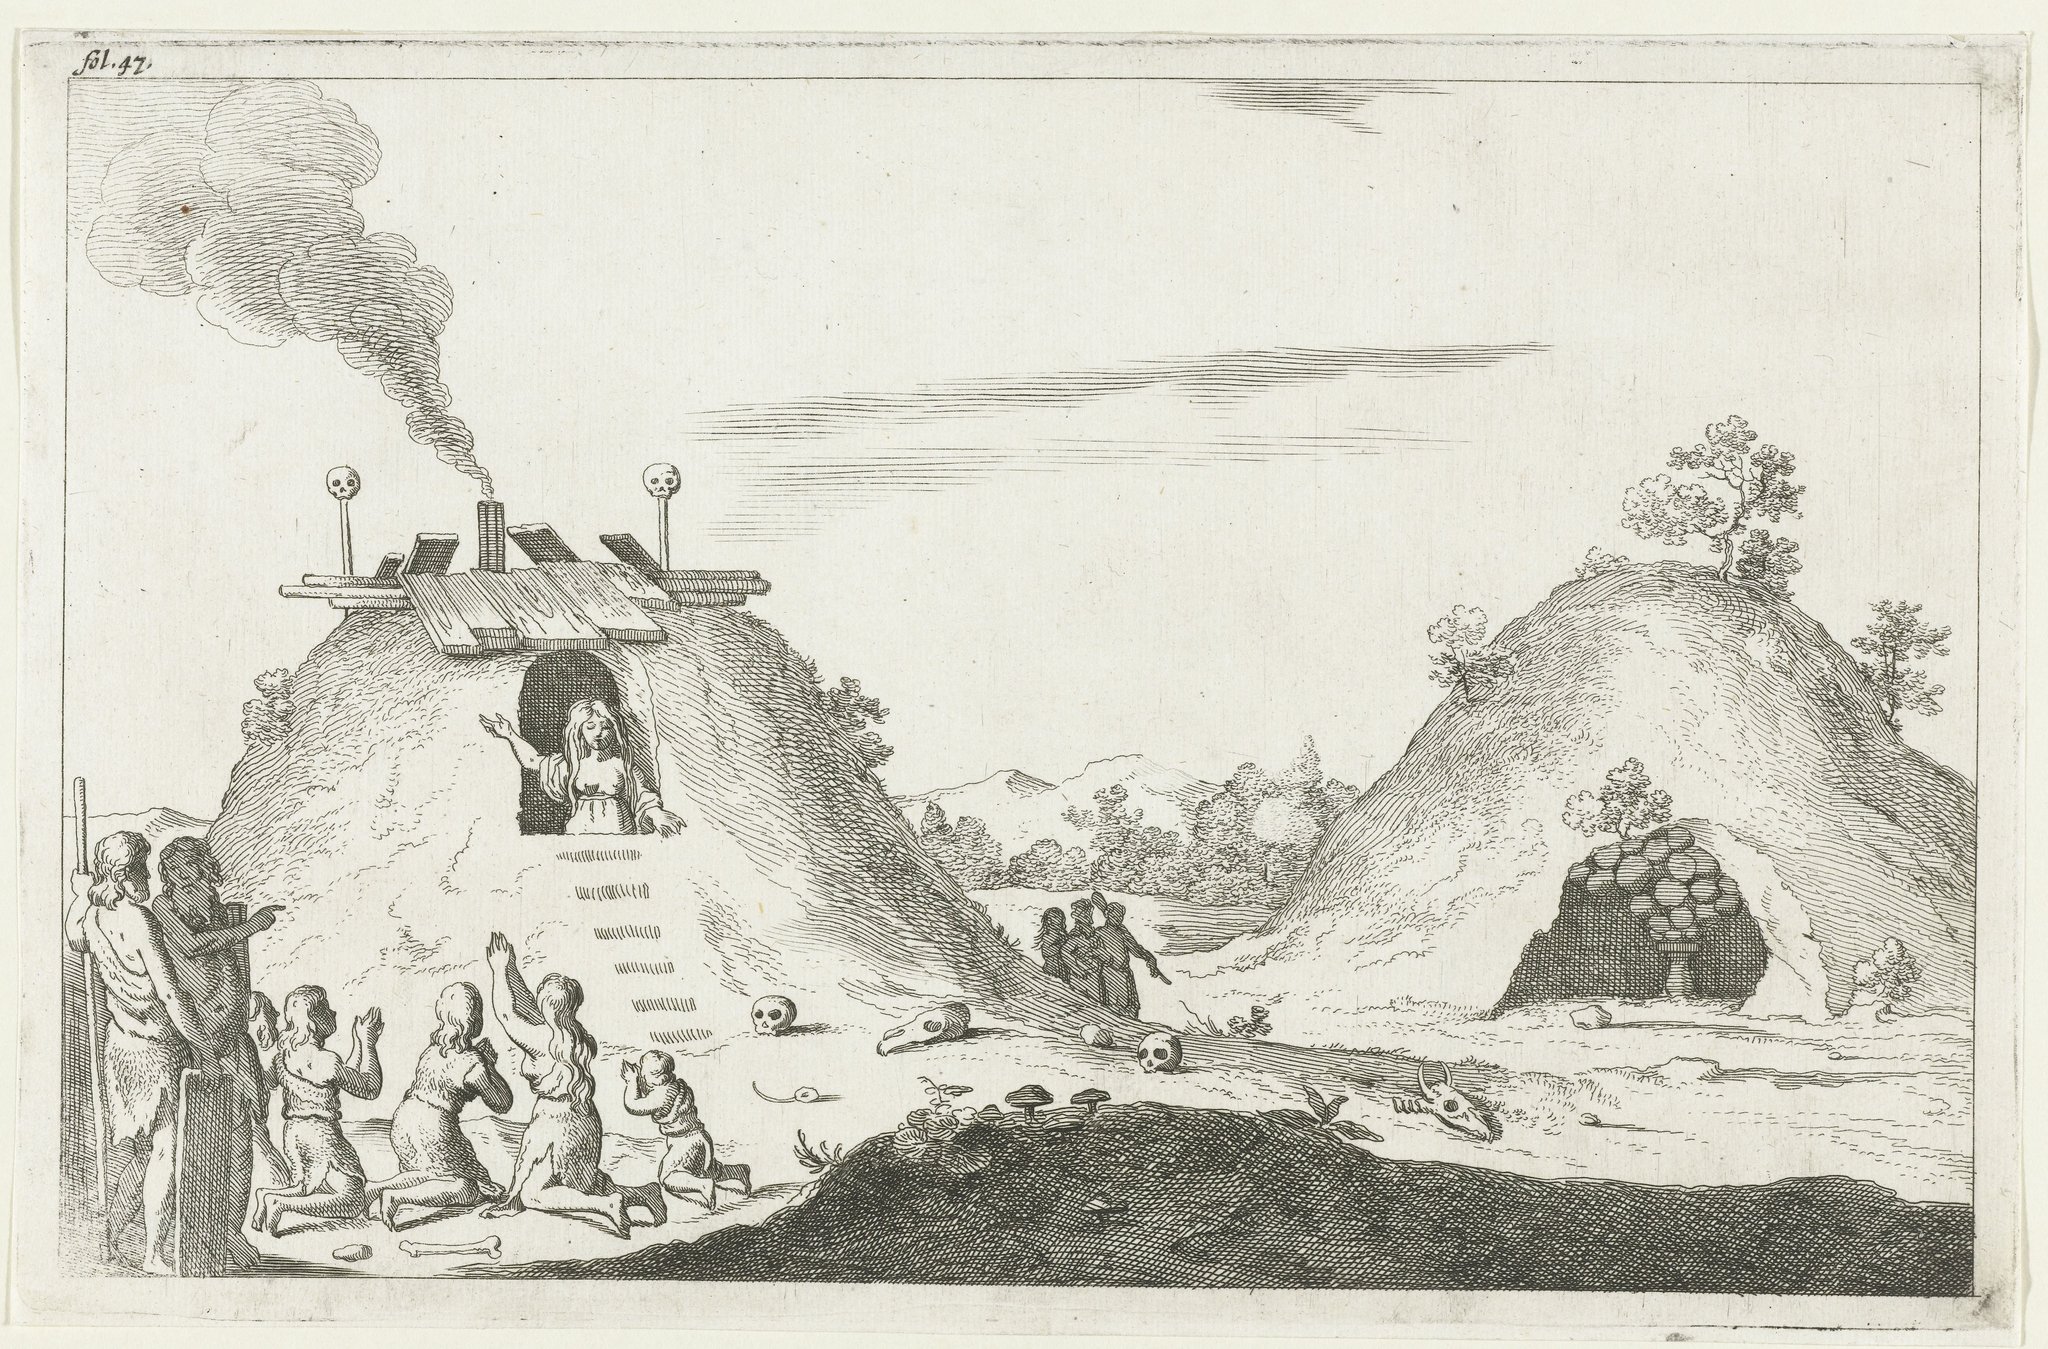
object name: history print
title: Priesteres spreekt vanuit een heuvel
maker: Anonymous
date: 1658-1660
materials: paper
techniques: etching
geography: netherlands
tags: germanic and scandinavian religions, extinct, 'historical' peoples (with name), netherlands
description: Priesteres spreekt vanuit een heuvel. Maakt deel uit van de acht illustraties in: Johan Picardt, Korte beschryvinge van eenige vergetene en verborgene antiquiteten … in het antiquiteet-rijcke landschap Drenth, Tymon Houthaak, Amsterdam 1660, fol. 47.